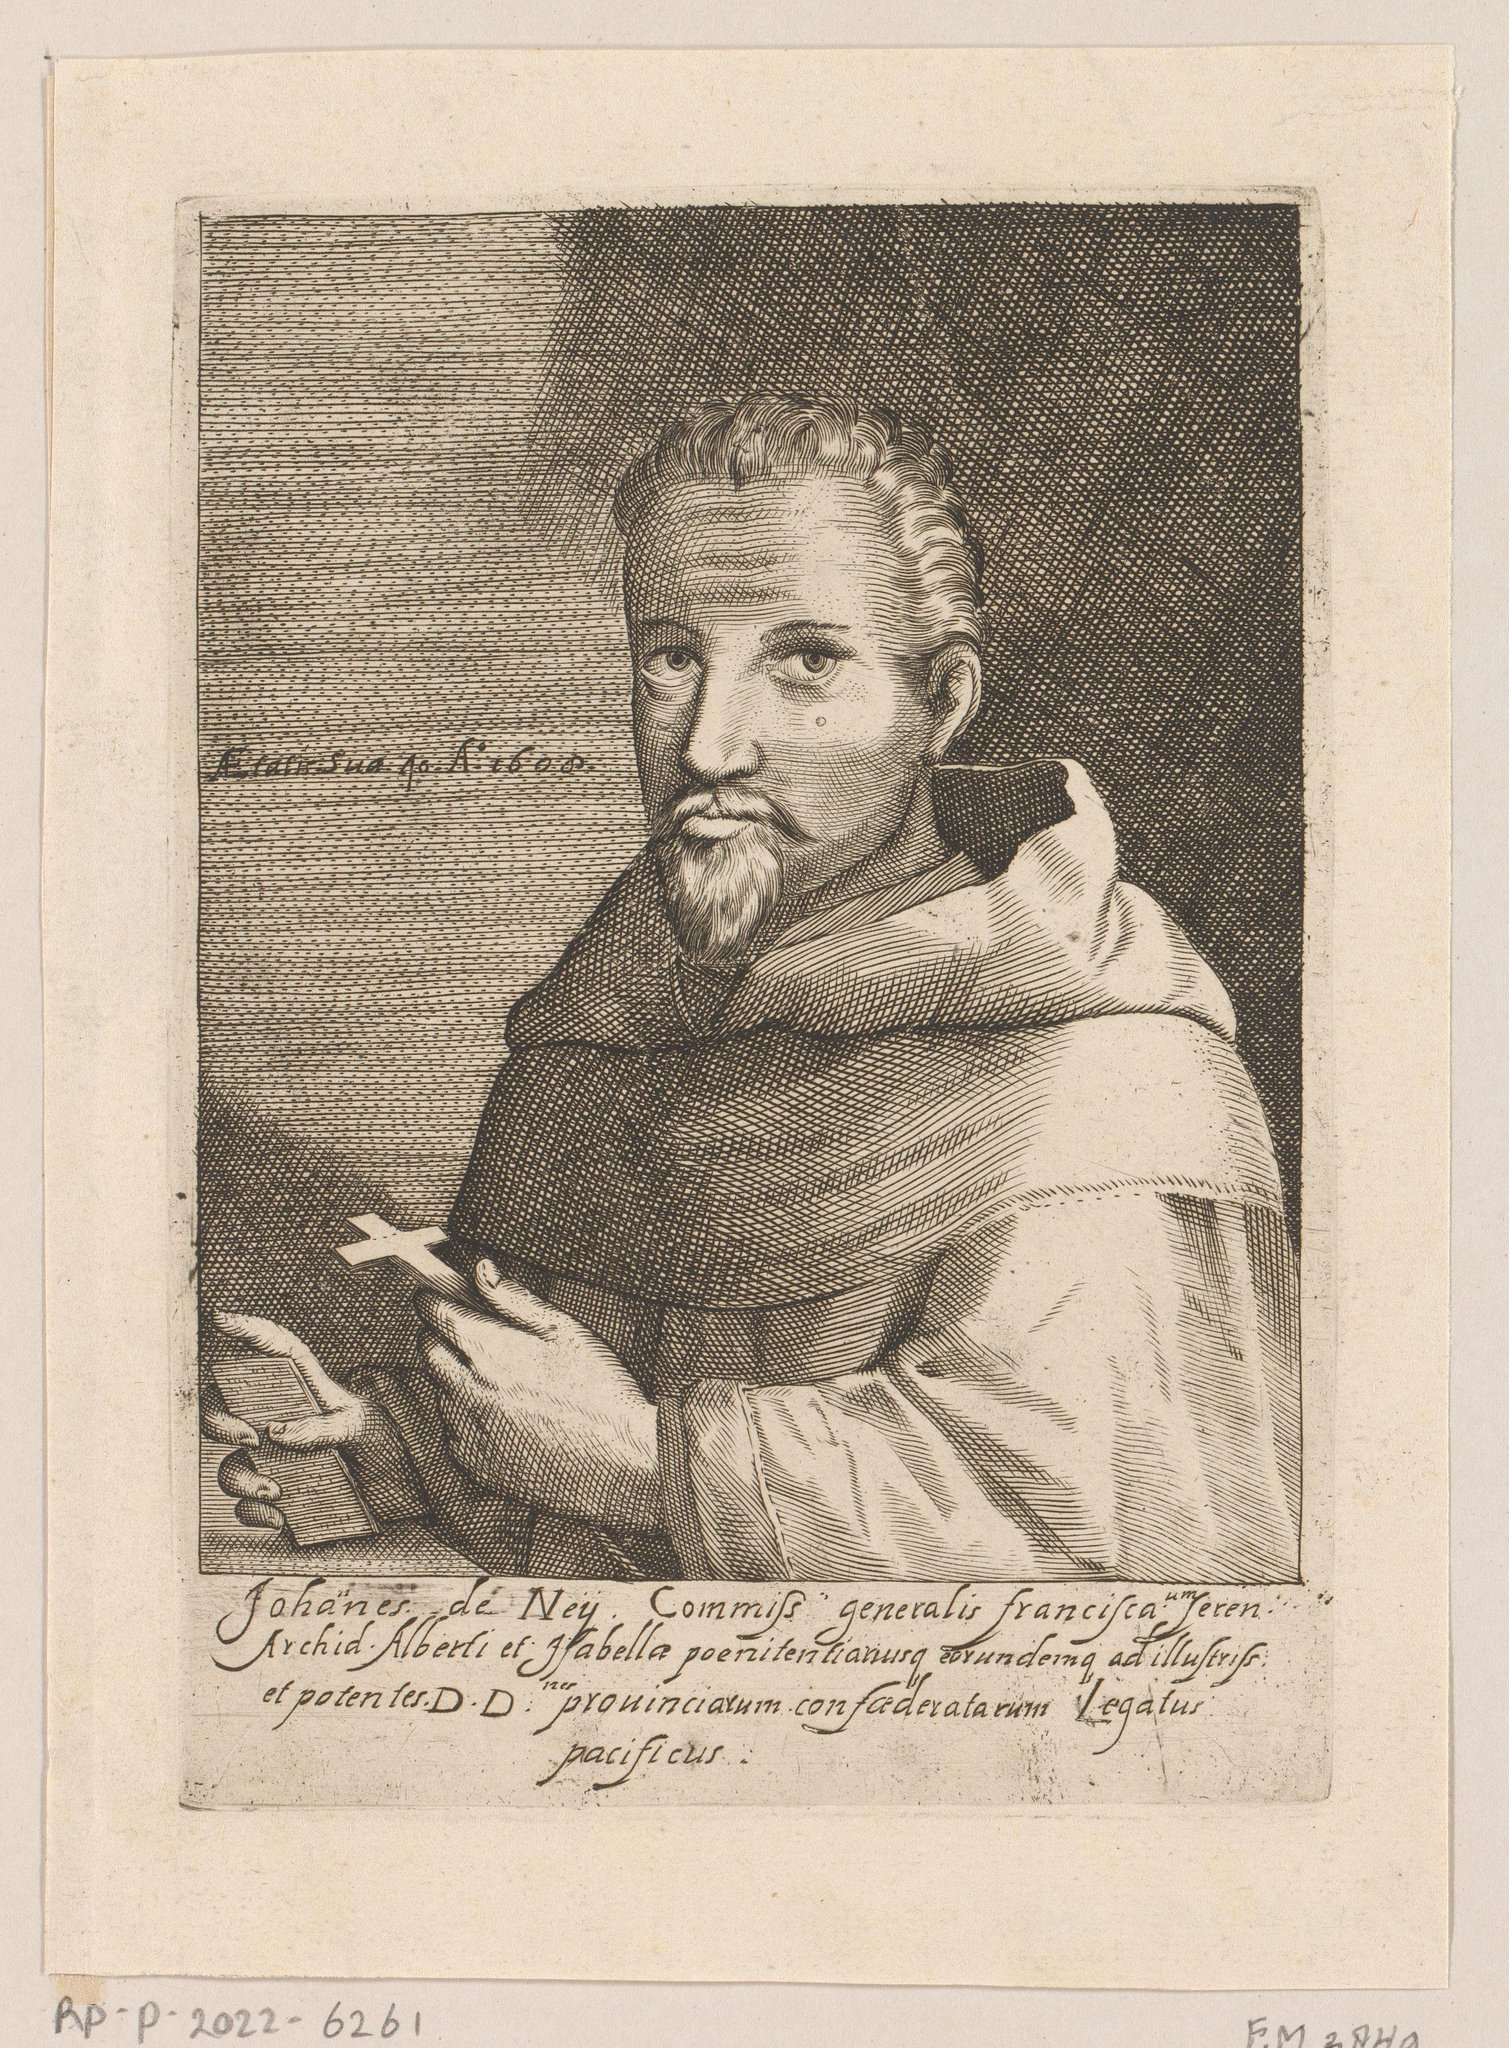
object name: print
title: Portret van Jan Neyen op 40-jarige leeftijd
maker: Anonymous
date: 1608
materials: paper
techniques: engraving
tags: antwerp, spain, historical persons, diplomacy, diplomat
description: Met vierregelig onderschrift in het Latijn.